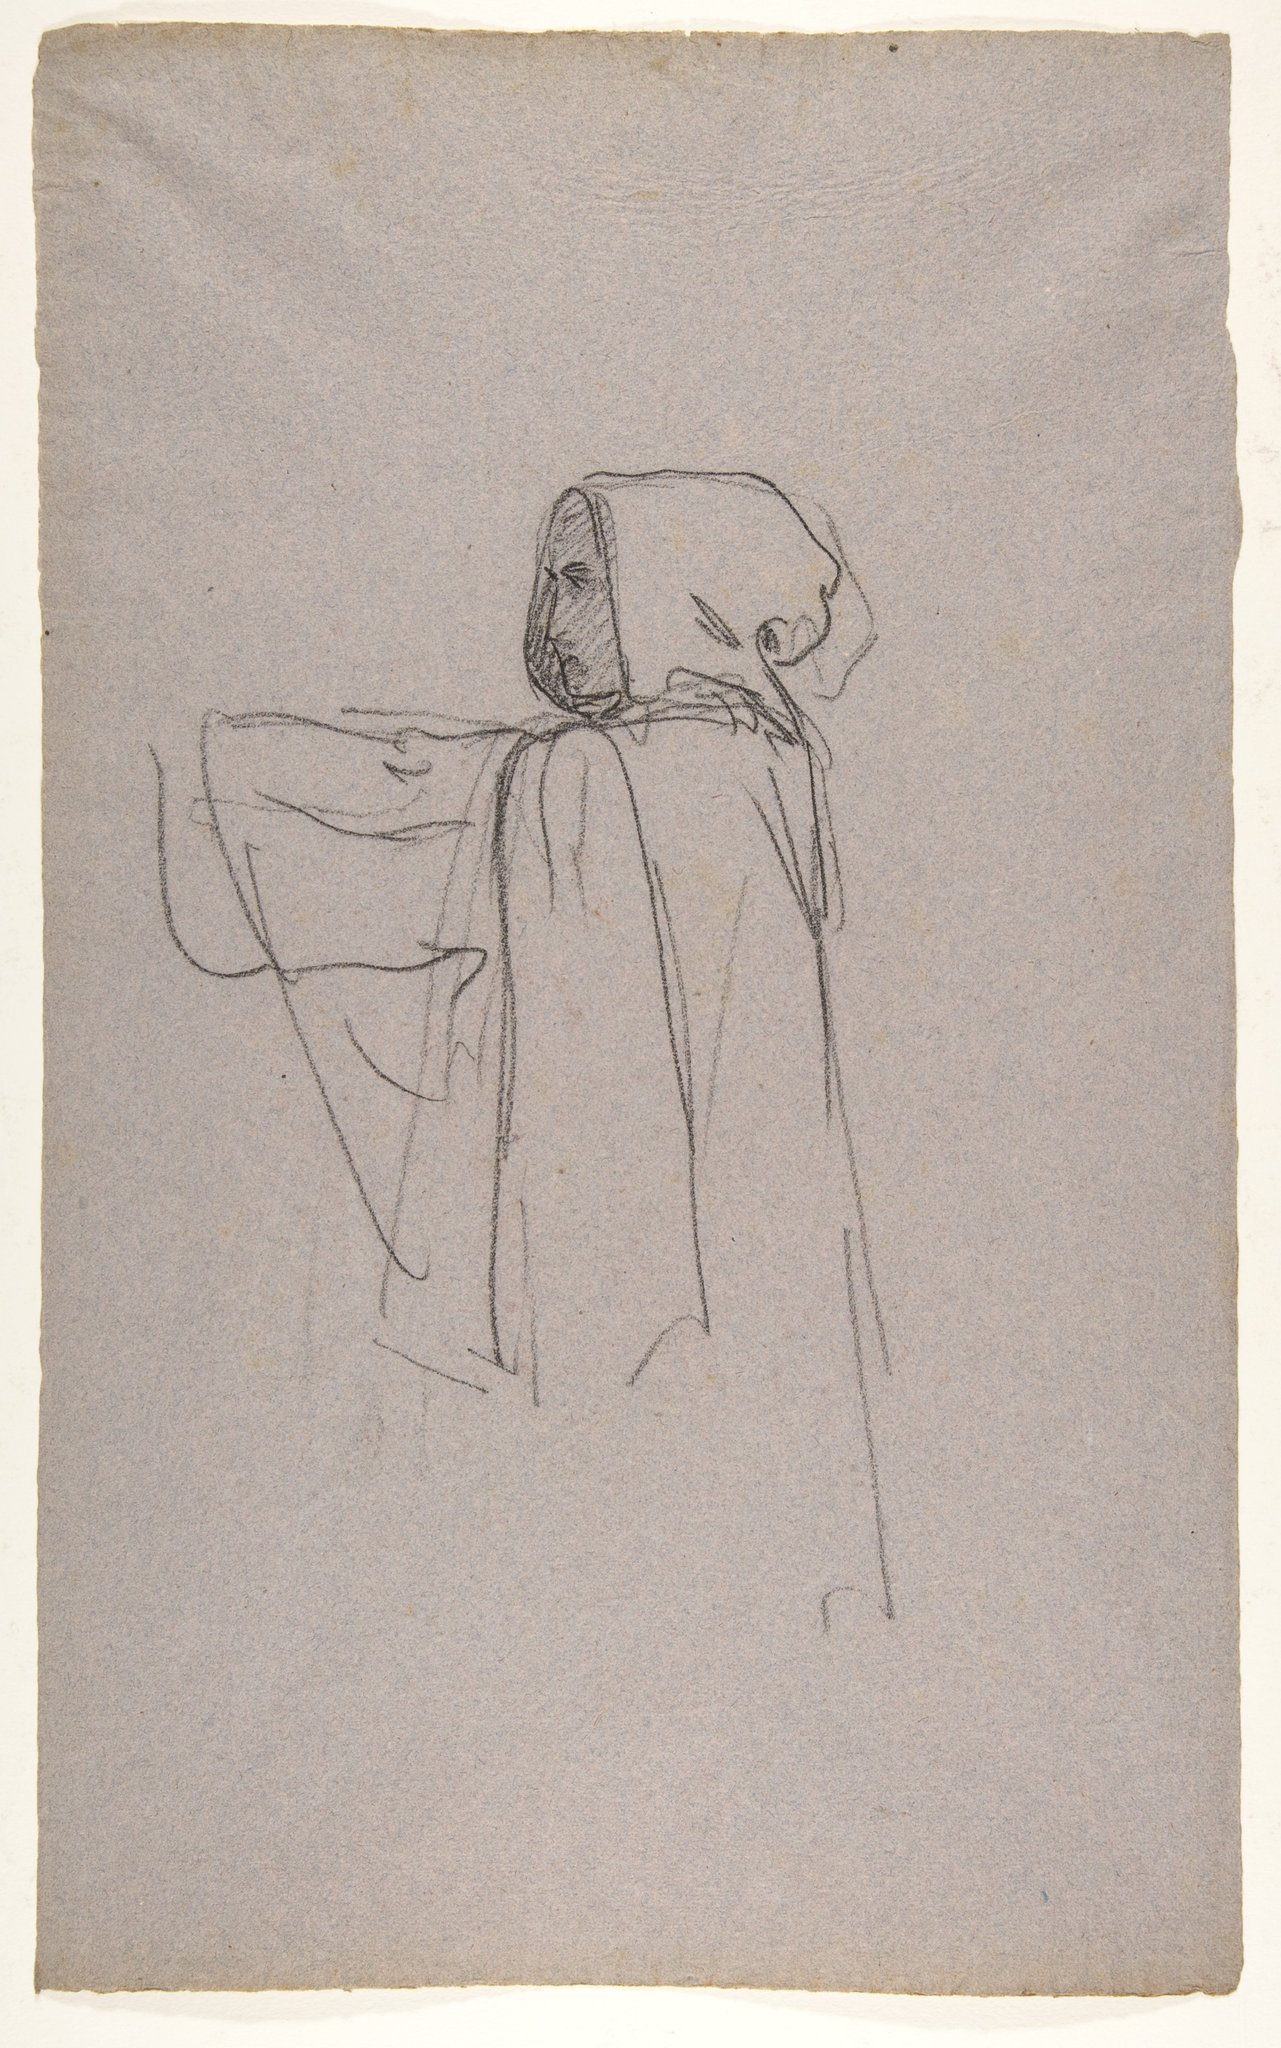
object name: drawing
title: Monk (lower register); verso: Drapery Study for a Bishop (lower register); (studies for wall paintings in the Chapel of Saint Remi, Sainte-Clotilde, Paris, 1858)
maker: isidore pils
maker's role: artist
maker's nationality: french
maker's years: 1813-1875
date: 1801-1900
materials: chalk, paper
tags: monks